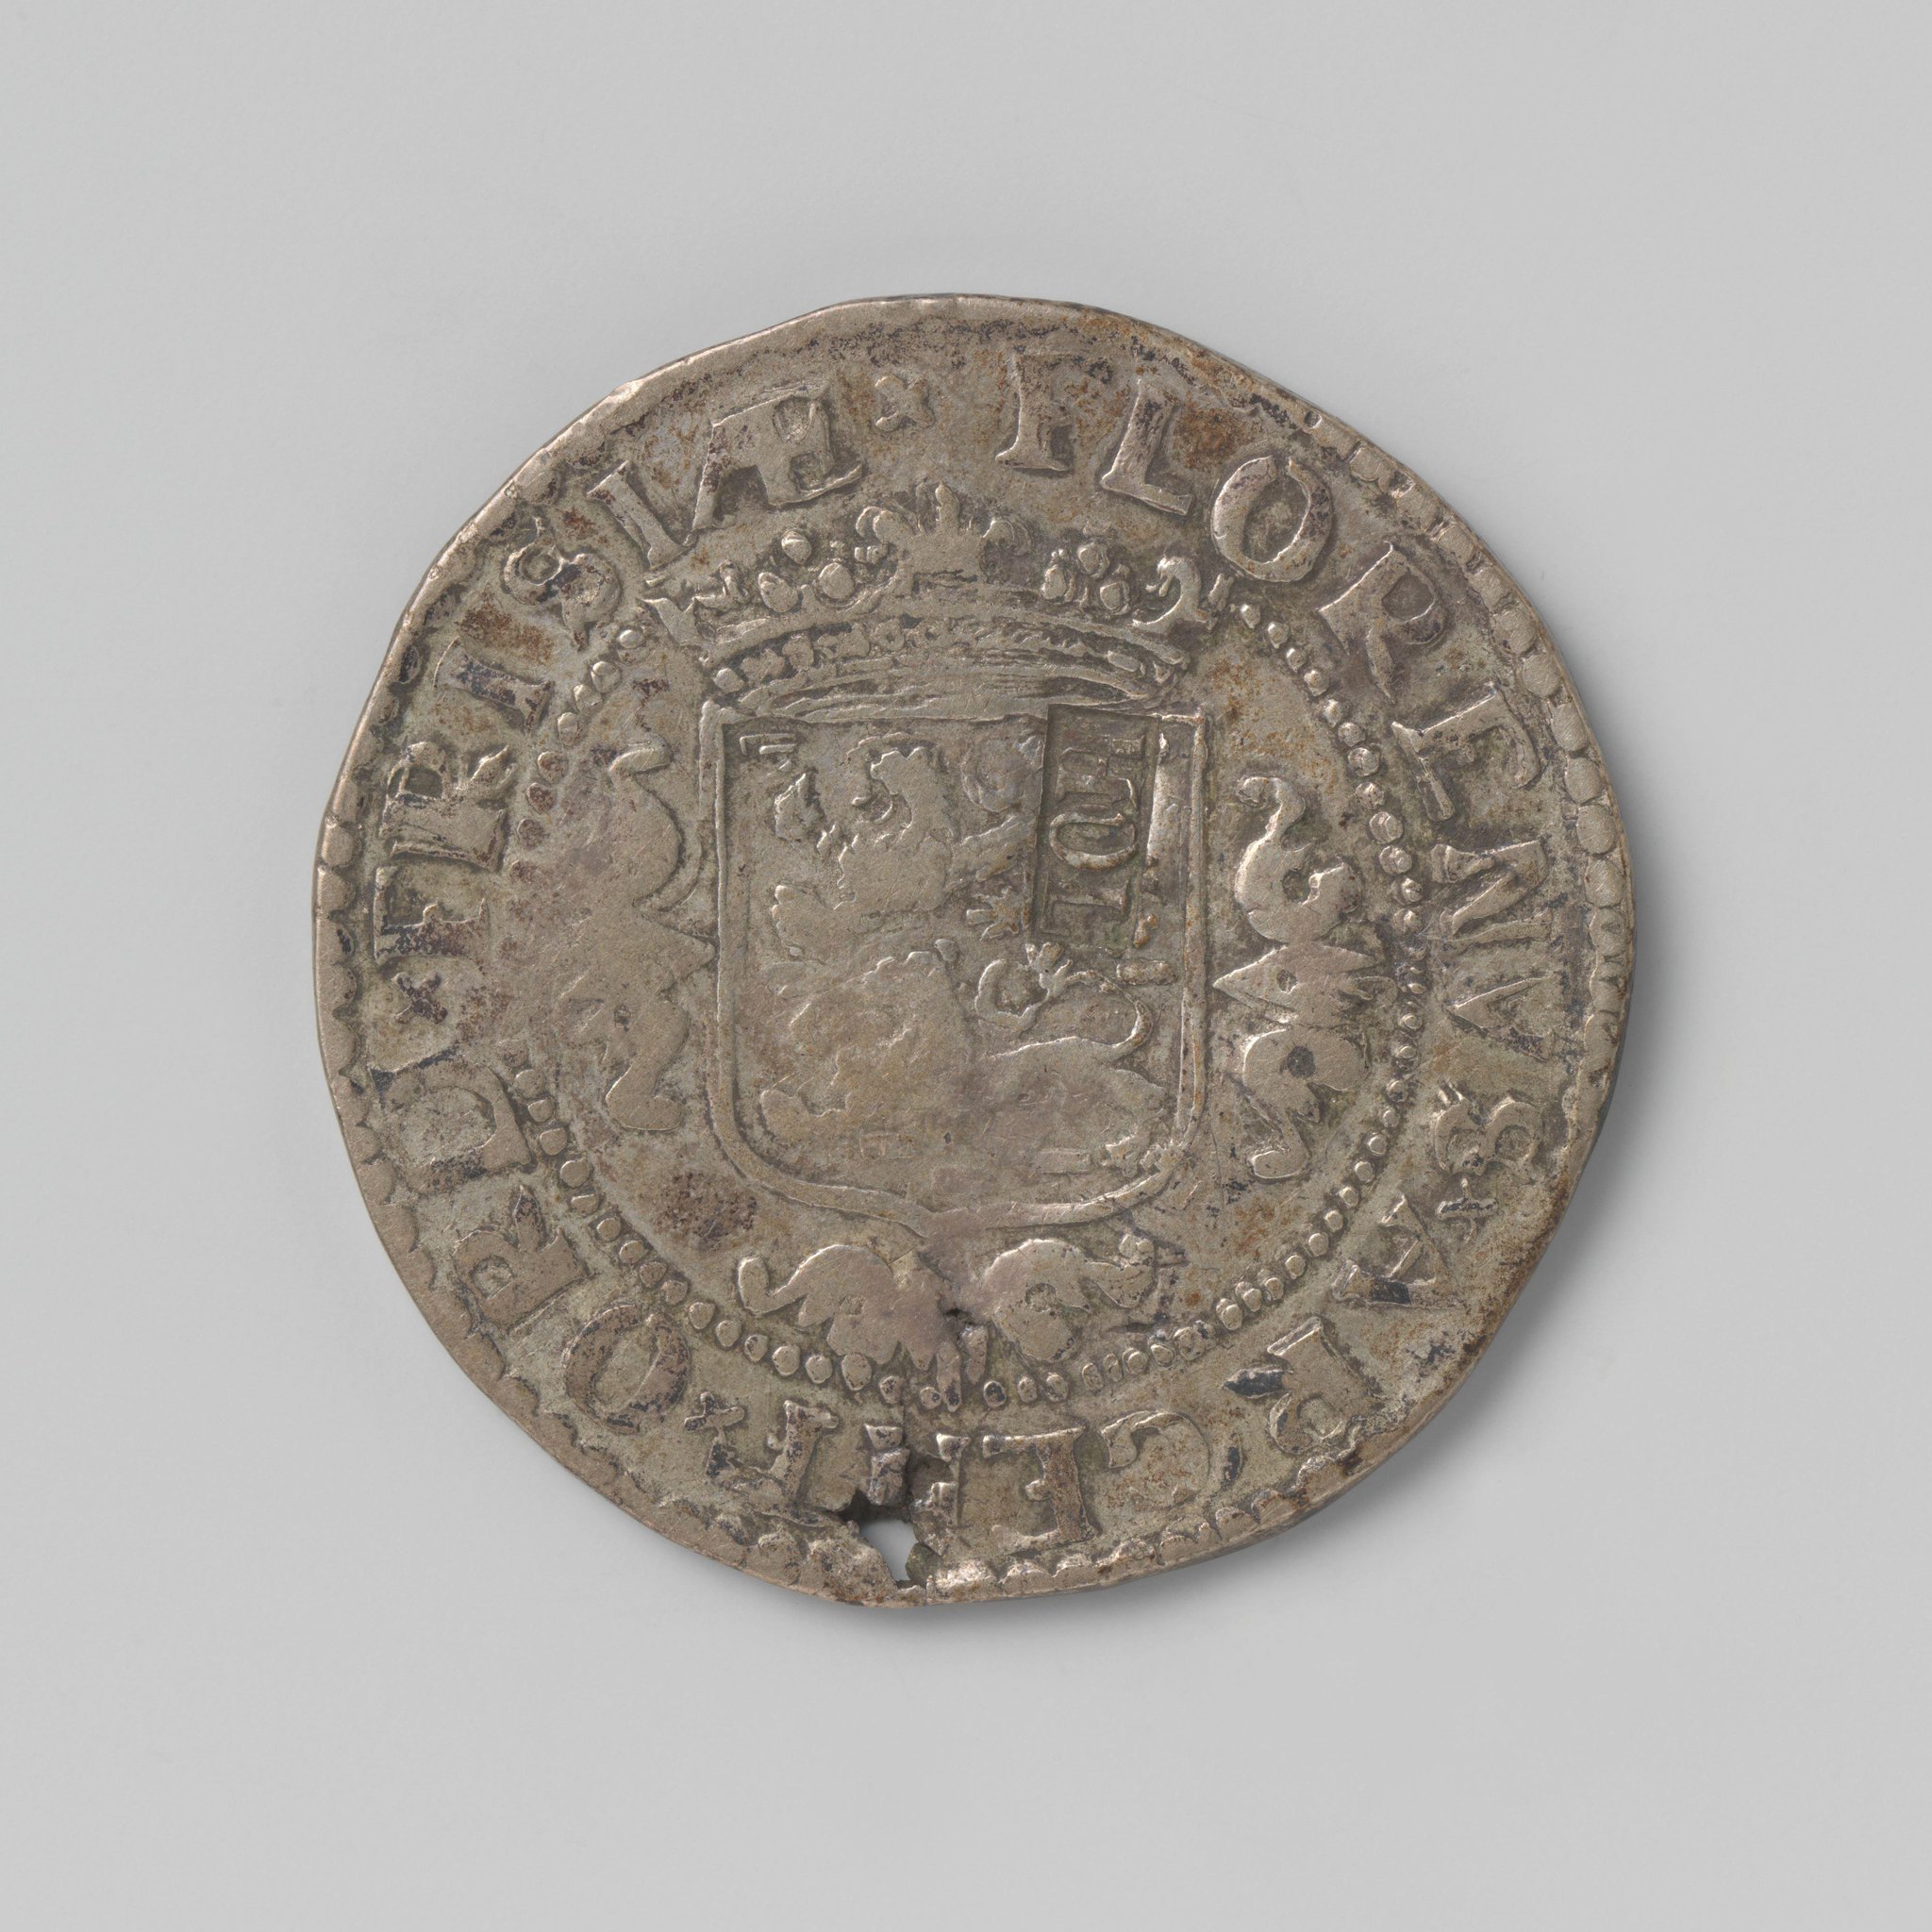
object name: florijn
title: Florijn van Friesland, 1665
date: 1665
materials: silver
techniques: striking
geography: leeuwarden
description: Zilveren munt. Voorzijde: tussen waarde-aanduiding edelman met muts naar rechts. In rechterhand zwaard. In omschrift jaartal Keerzijde: op kort gebloemd kruis gekroond wapenschild van Friesland. Op keerzijde klop HOL.